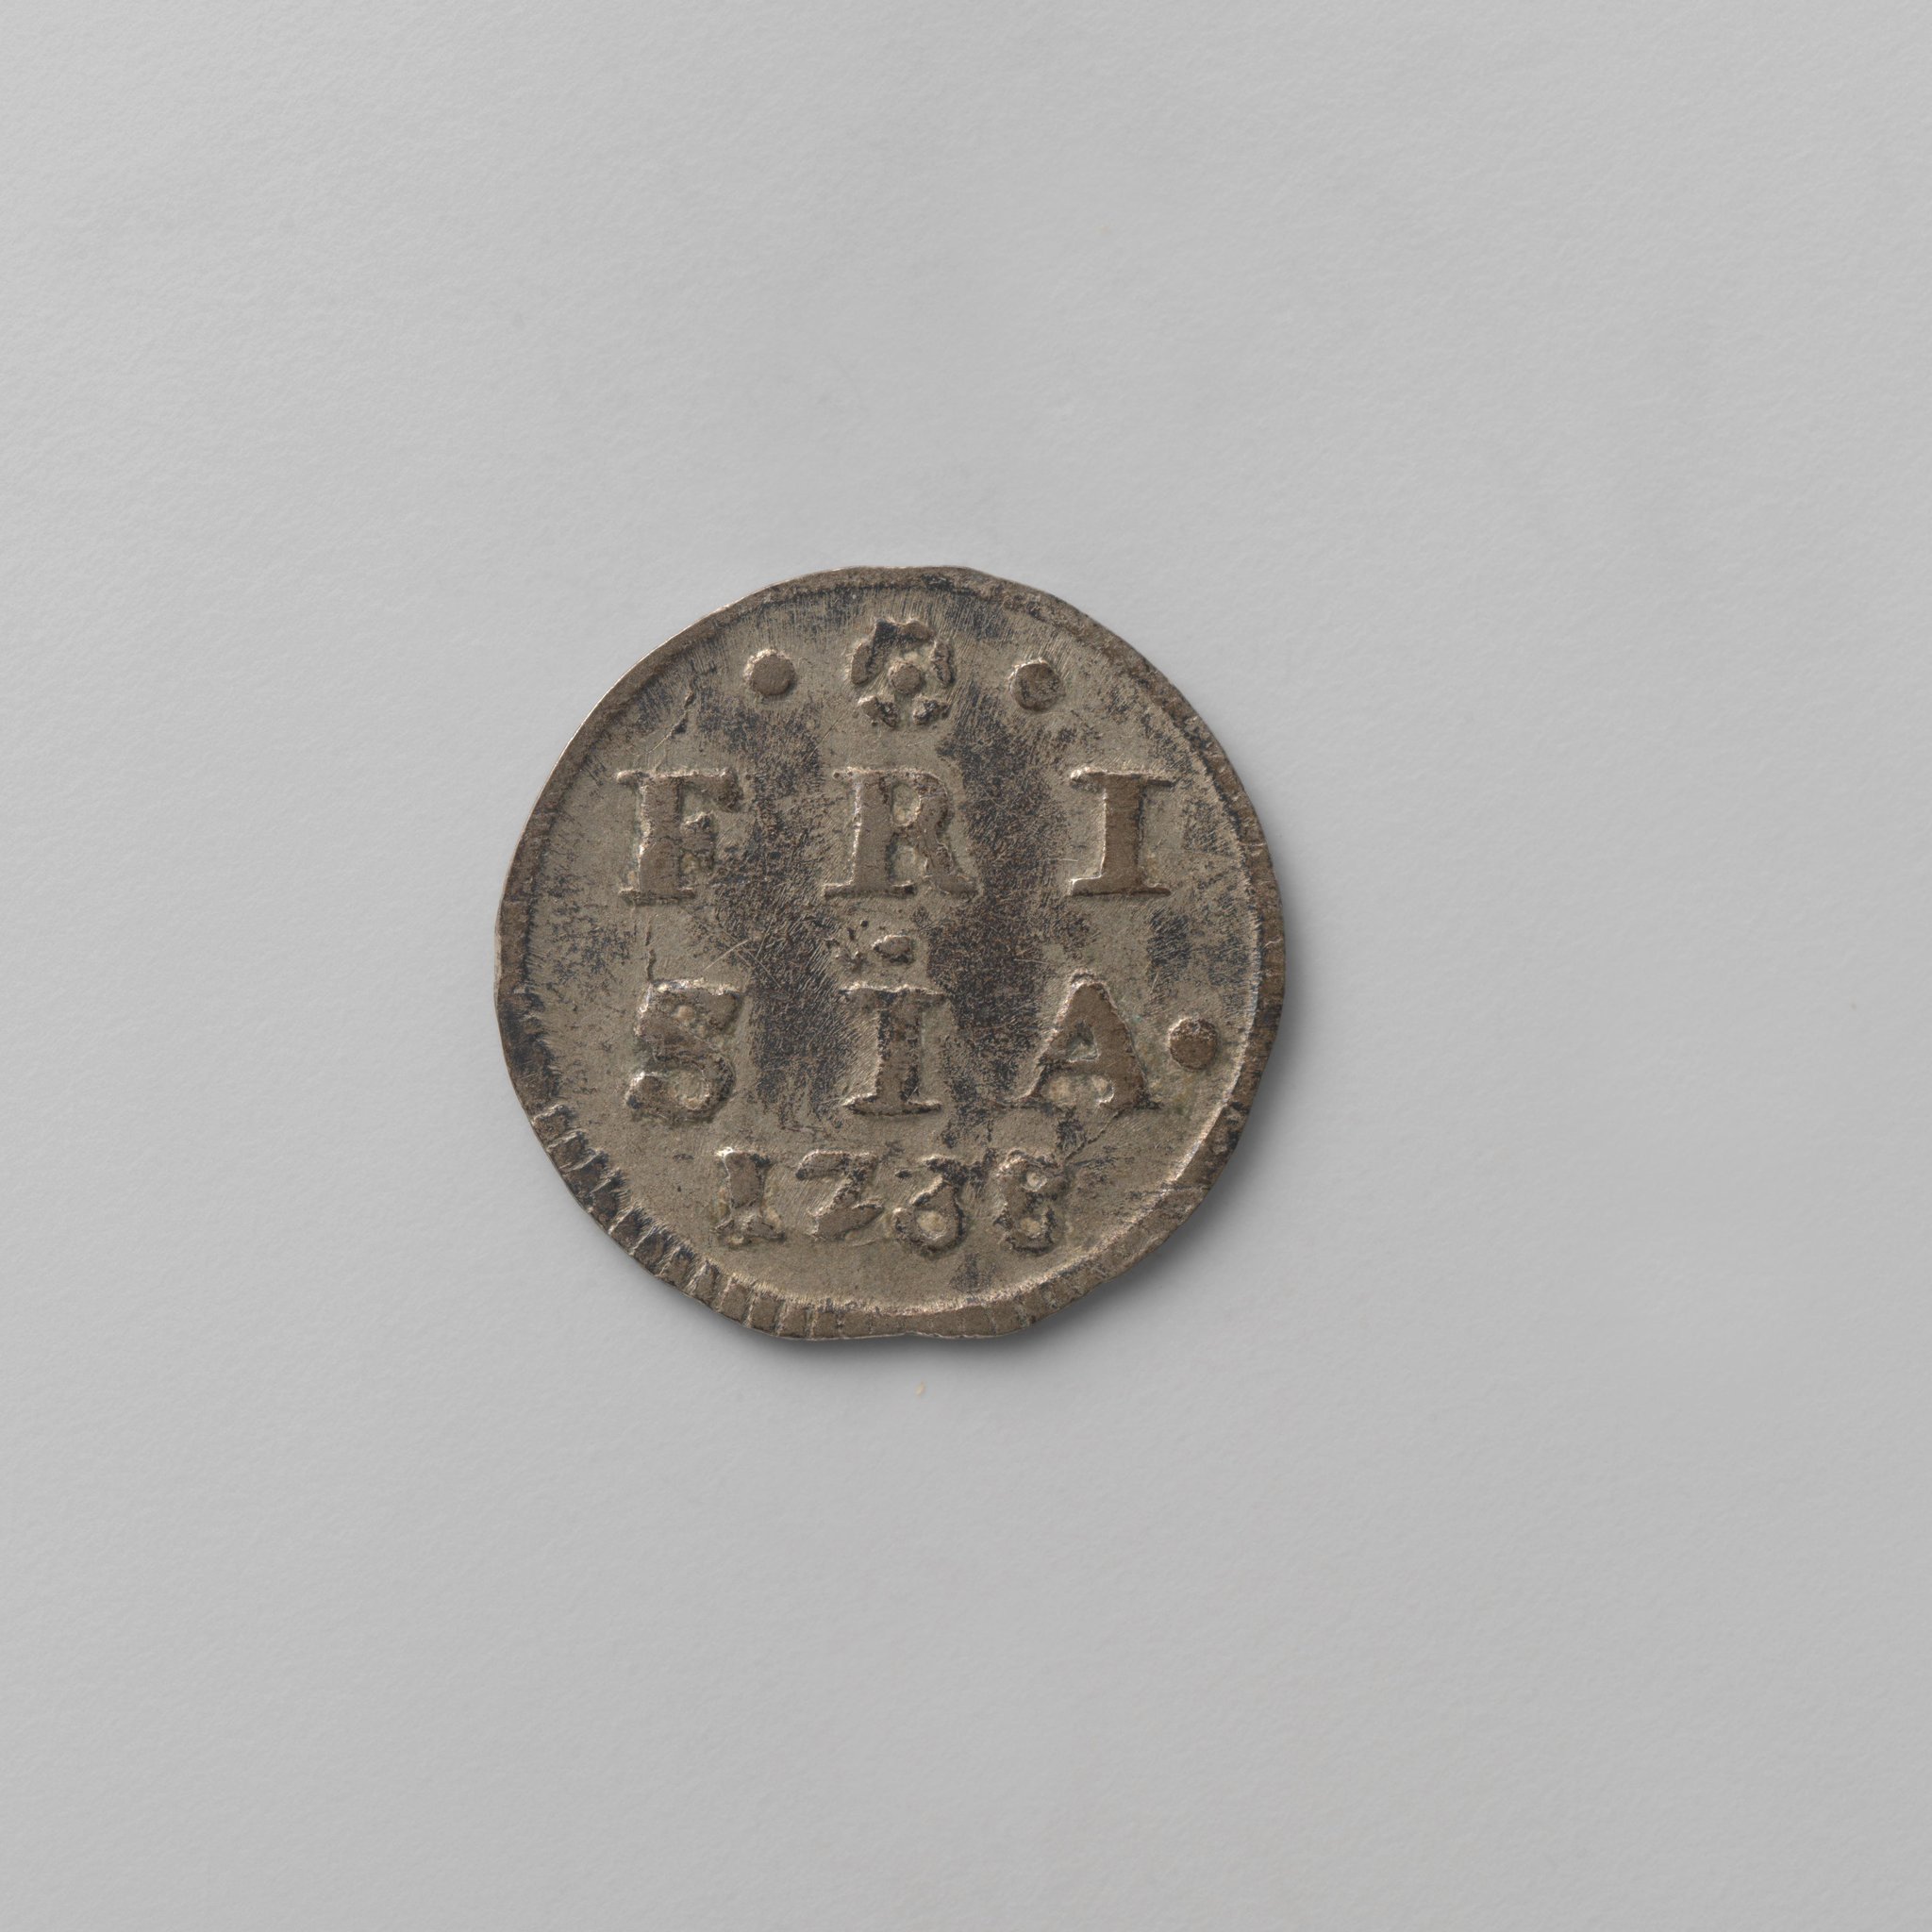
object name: coin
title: Friesland, bezemstuiver, 1738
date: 1738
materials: silver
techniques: striking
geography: leeuwarden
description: Zilveren munt. Voorzijde: binnen een lauwerkrans tussen waarde-aanduiding 1 S pijlenbundel. Keerzijde: Onder muntteken tussen twee punten opschrift in twee regels, waaronder jaartal.